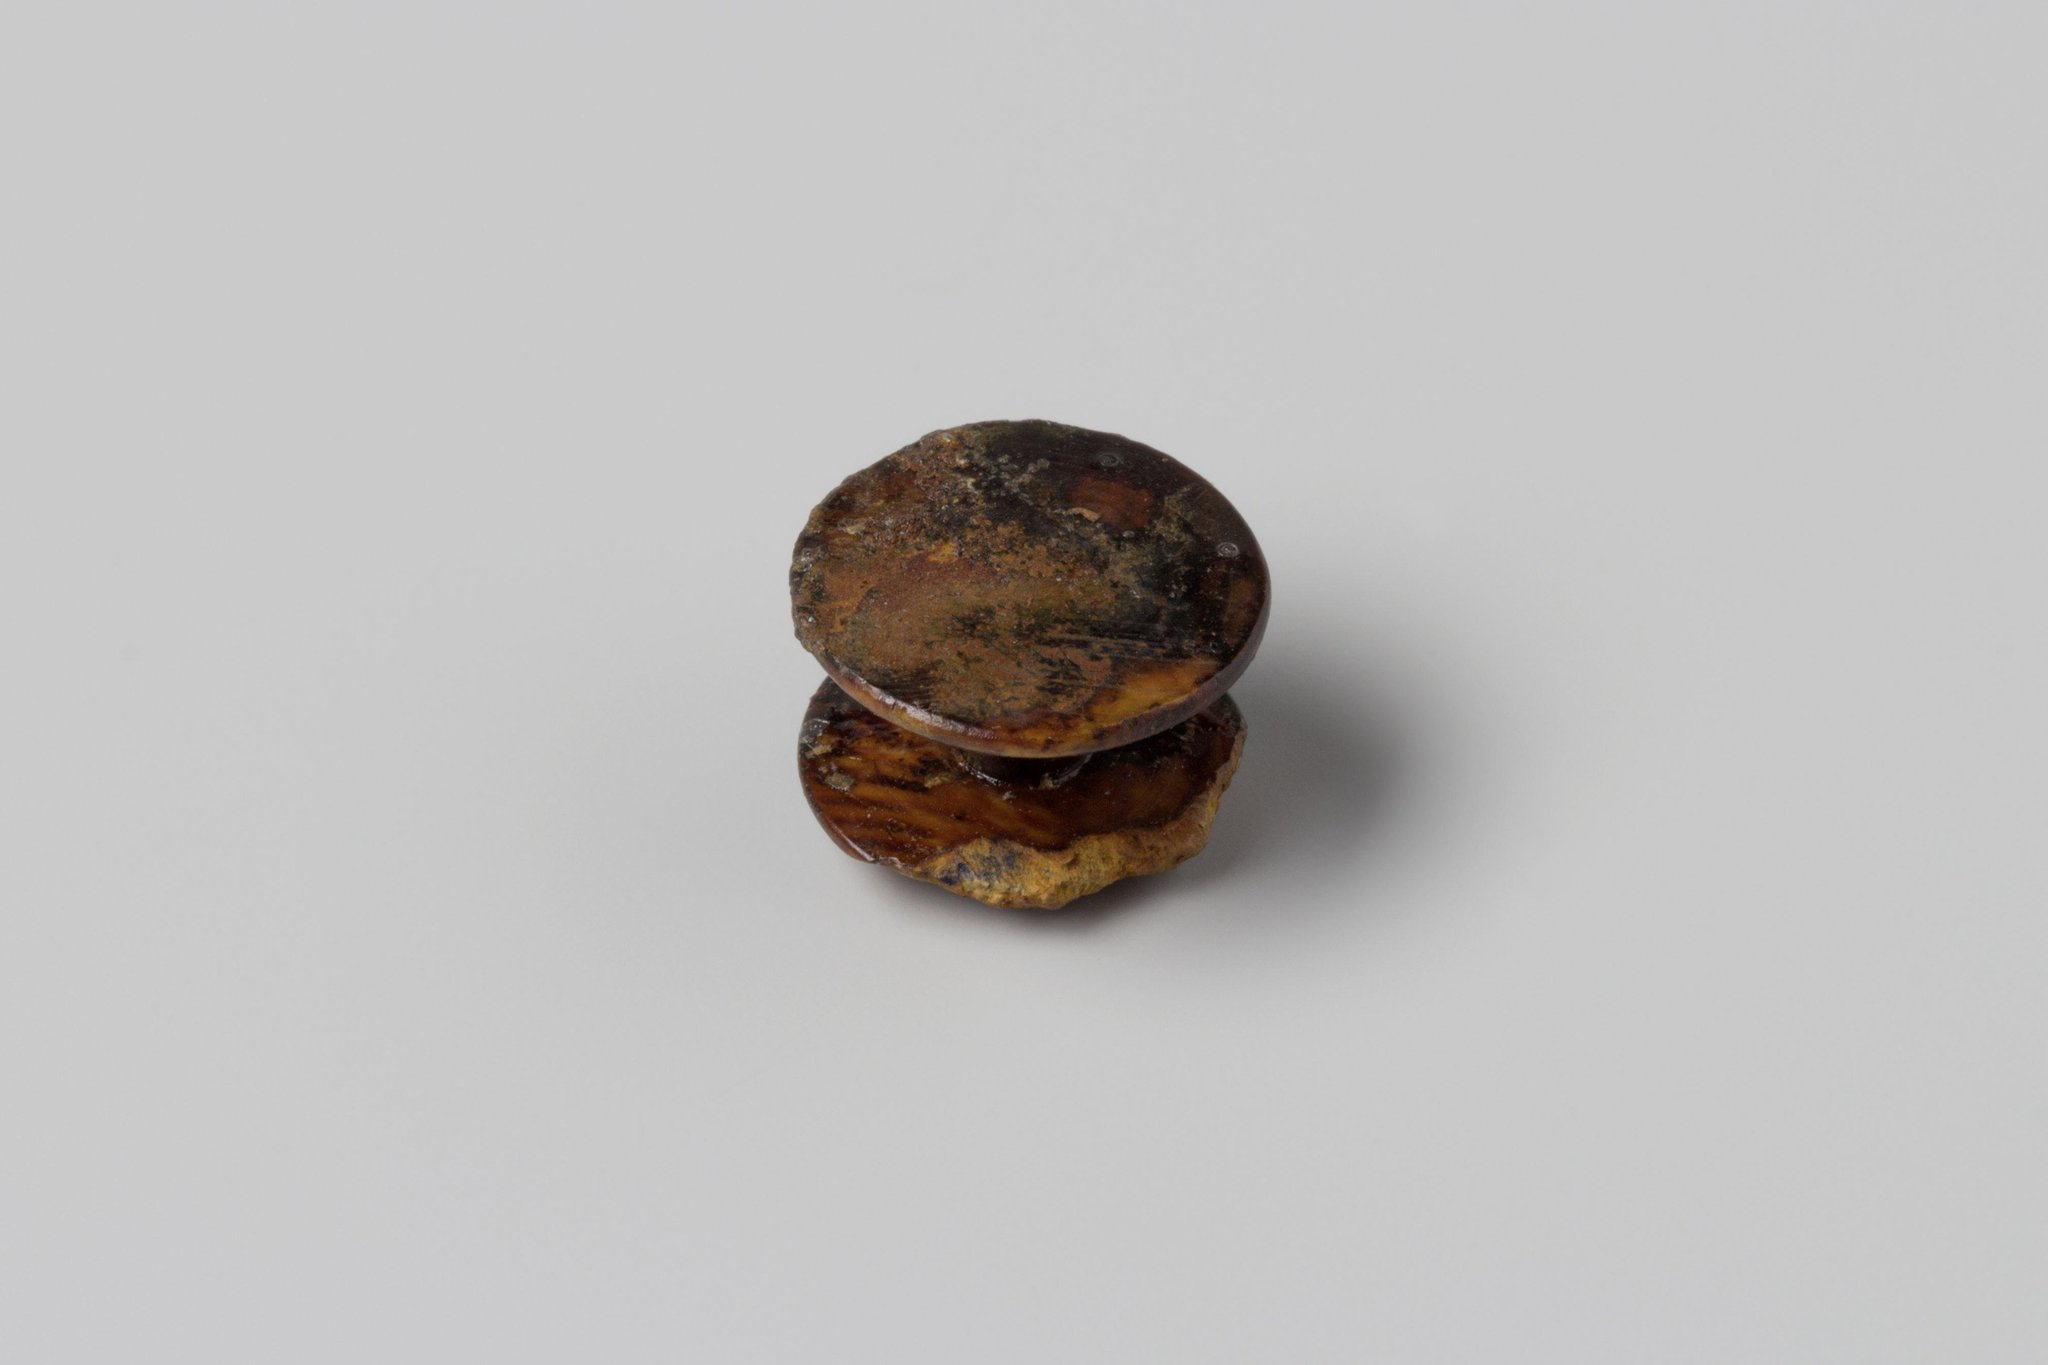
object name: collar button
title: Boordeknoopje uit het wrak van de Oost-Indiëvaarder Hollandia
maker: Anonymous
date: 1700-1743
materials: bone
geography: netherlands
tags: verenigde oostindische compagnie, hollandia (schip), annet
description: Boordeknoop. Stud; (1) circular, flat, plain, eroded (1.3d).